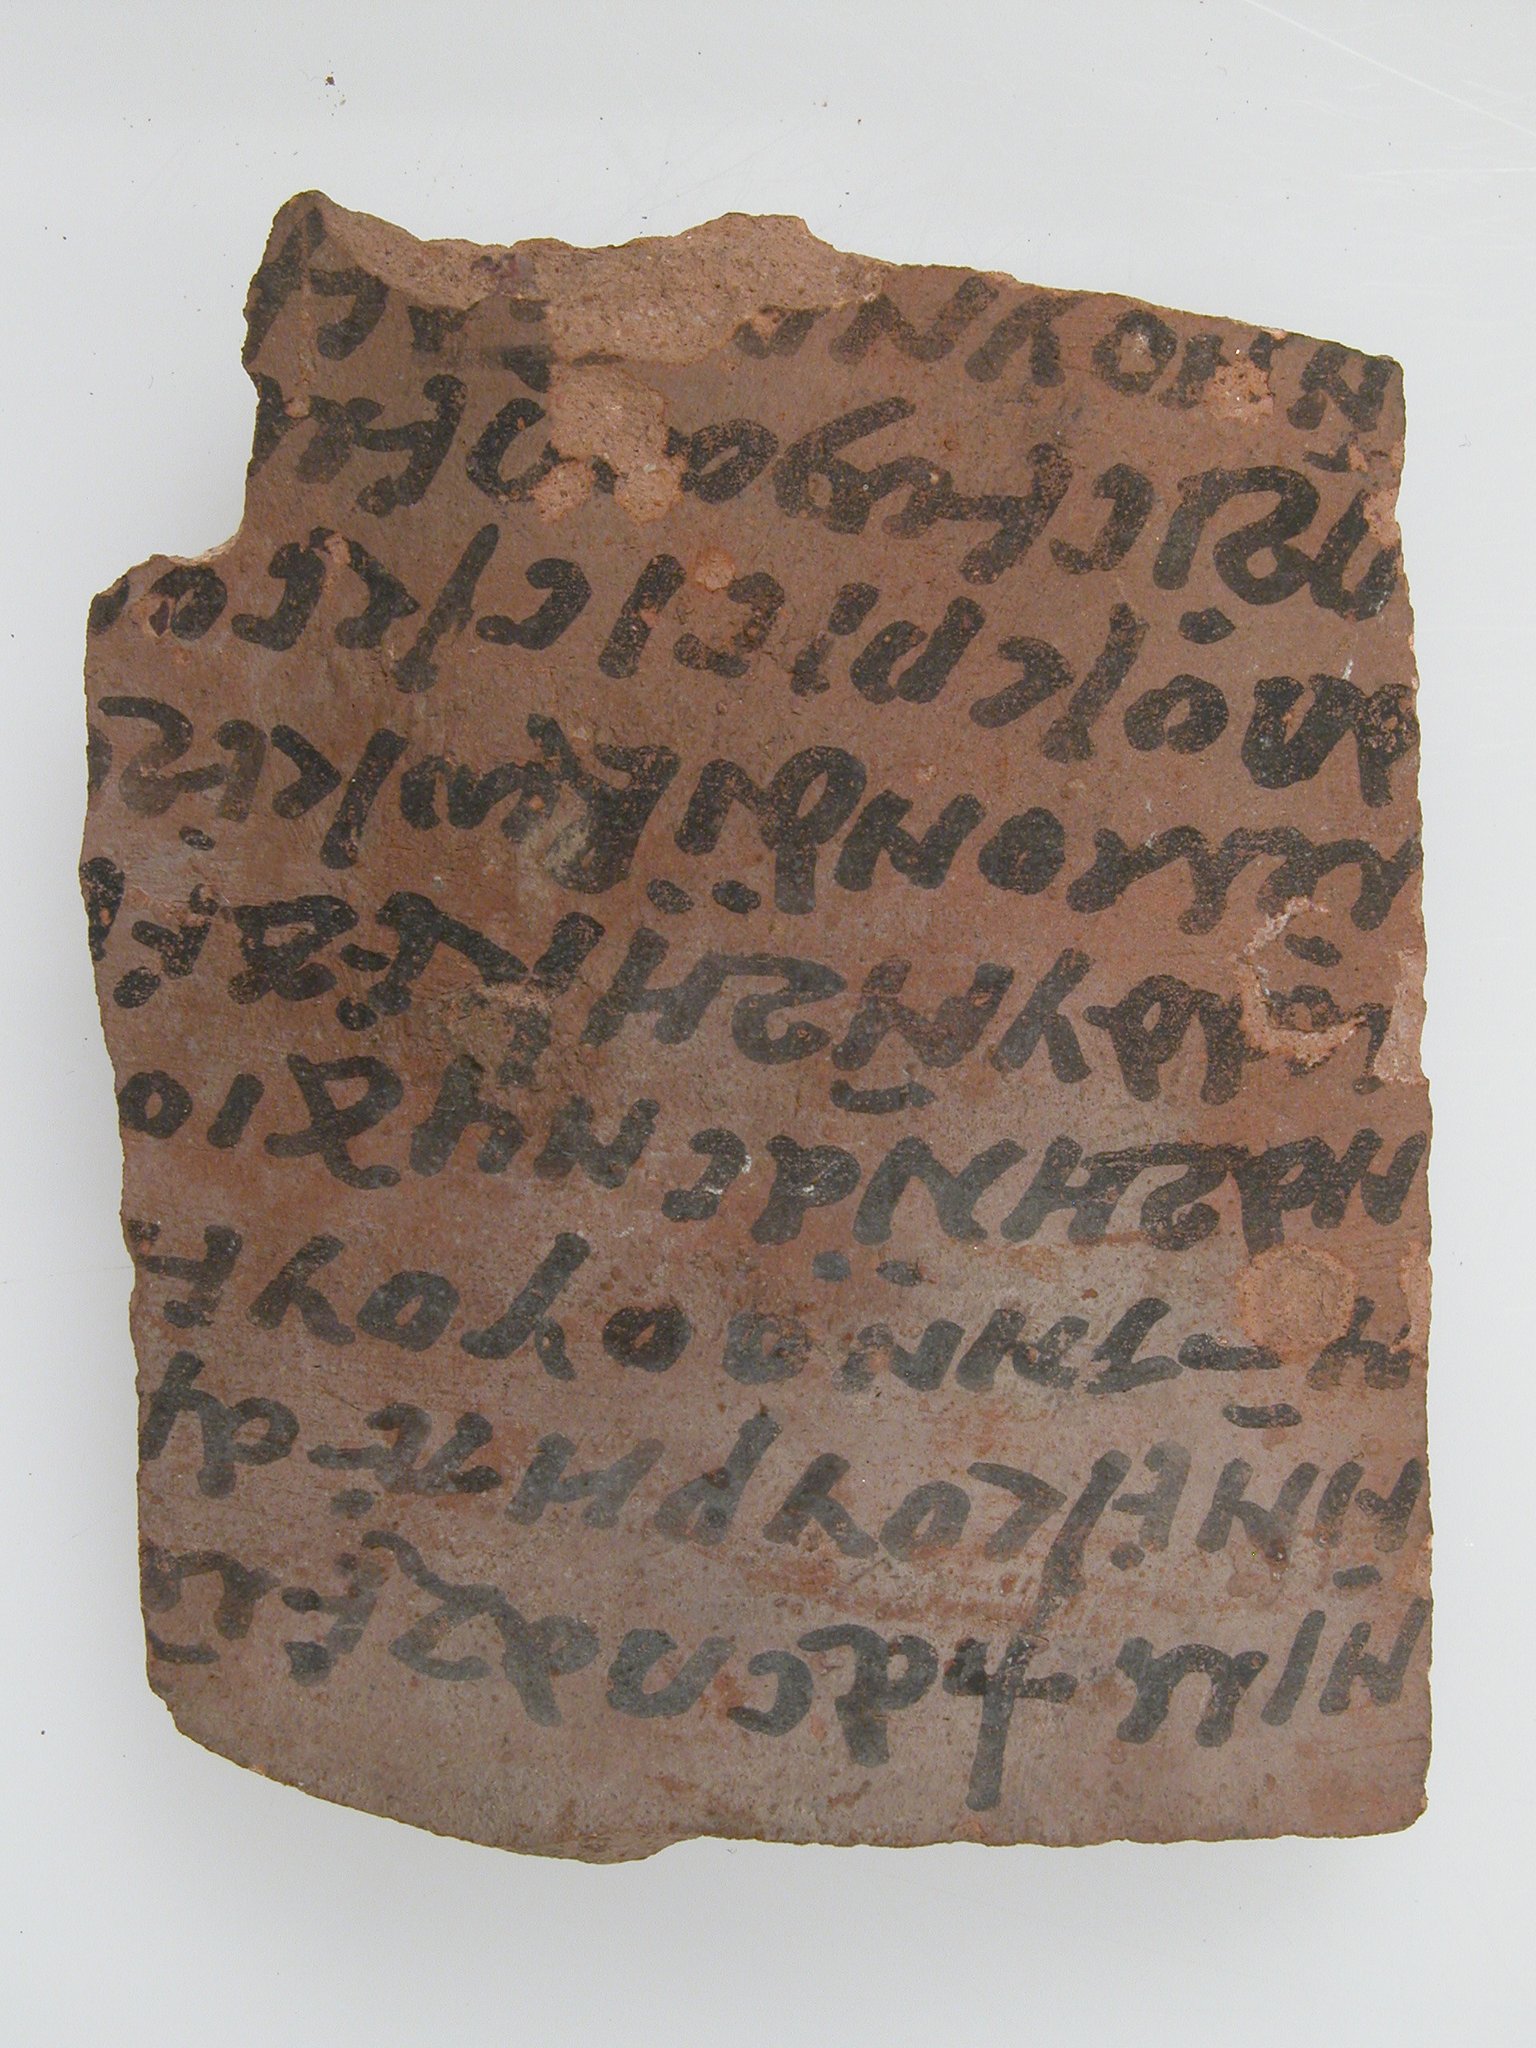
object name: ostrakon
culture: coptic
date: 600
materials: ink, pottery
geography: egypt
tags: coptic,documents